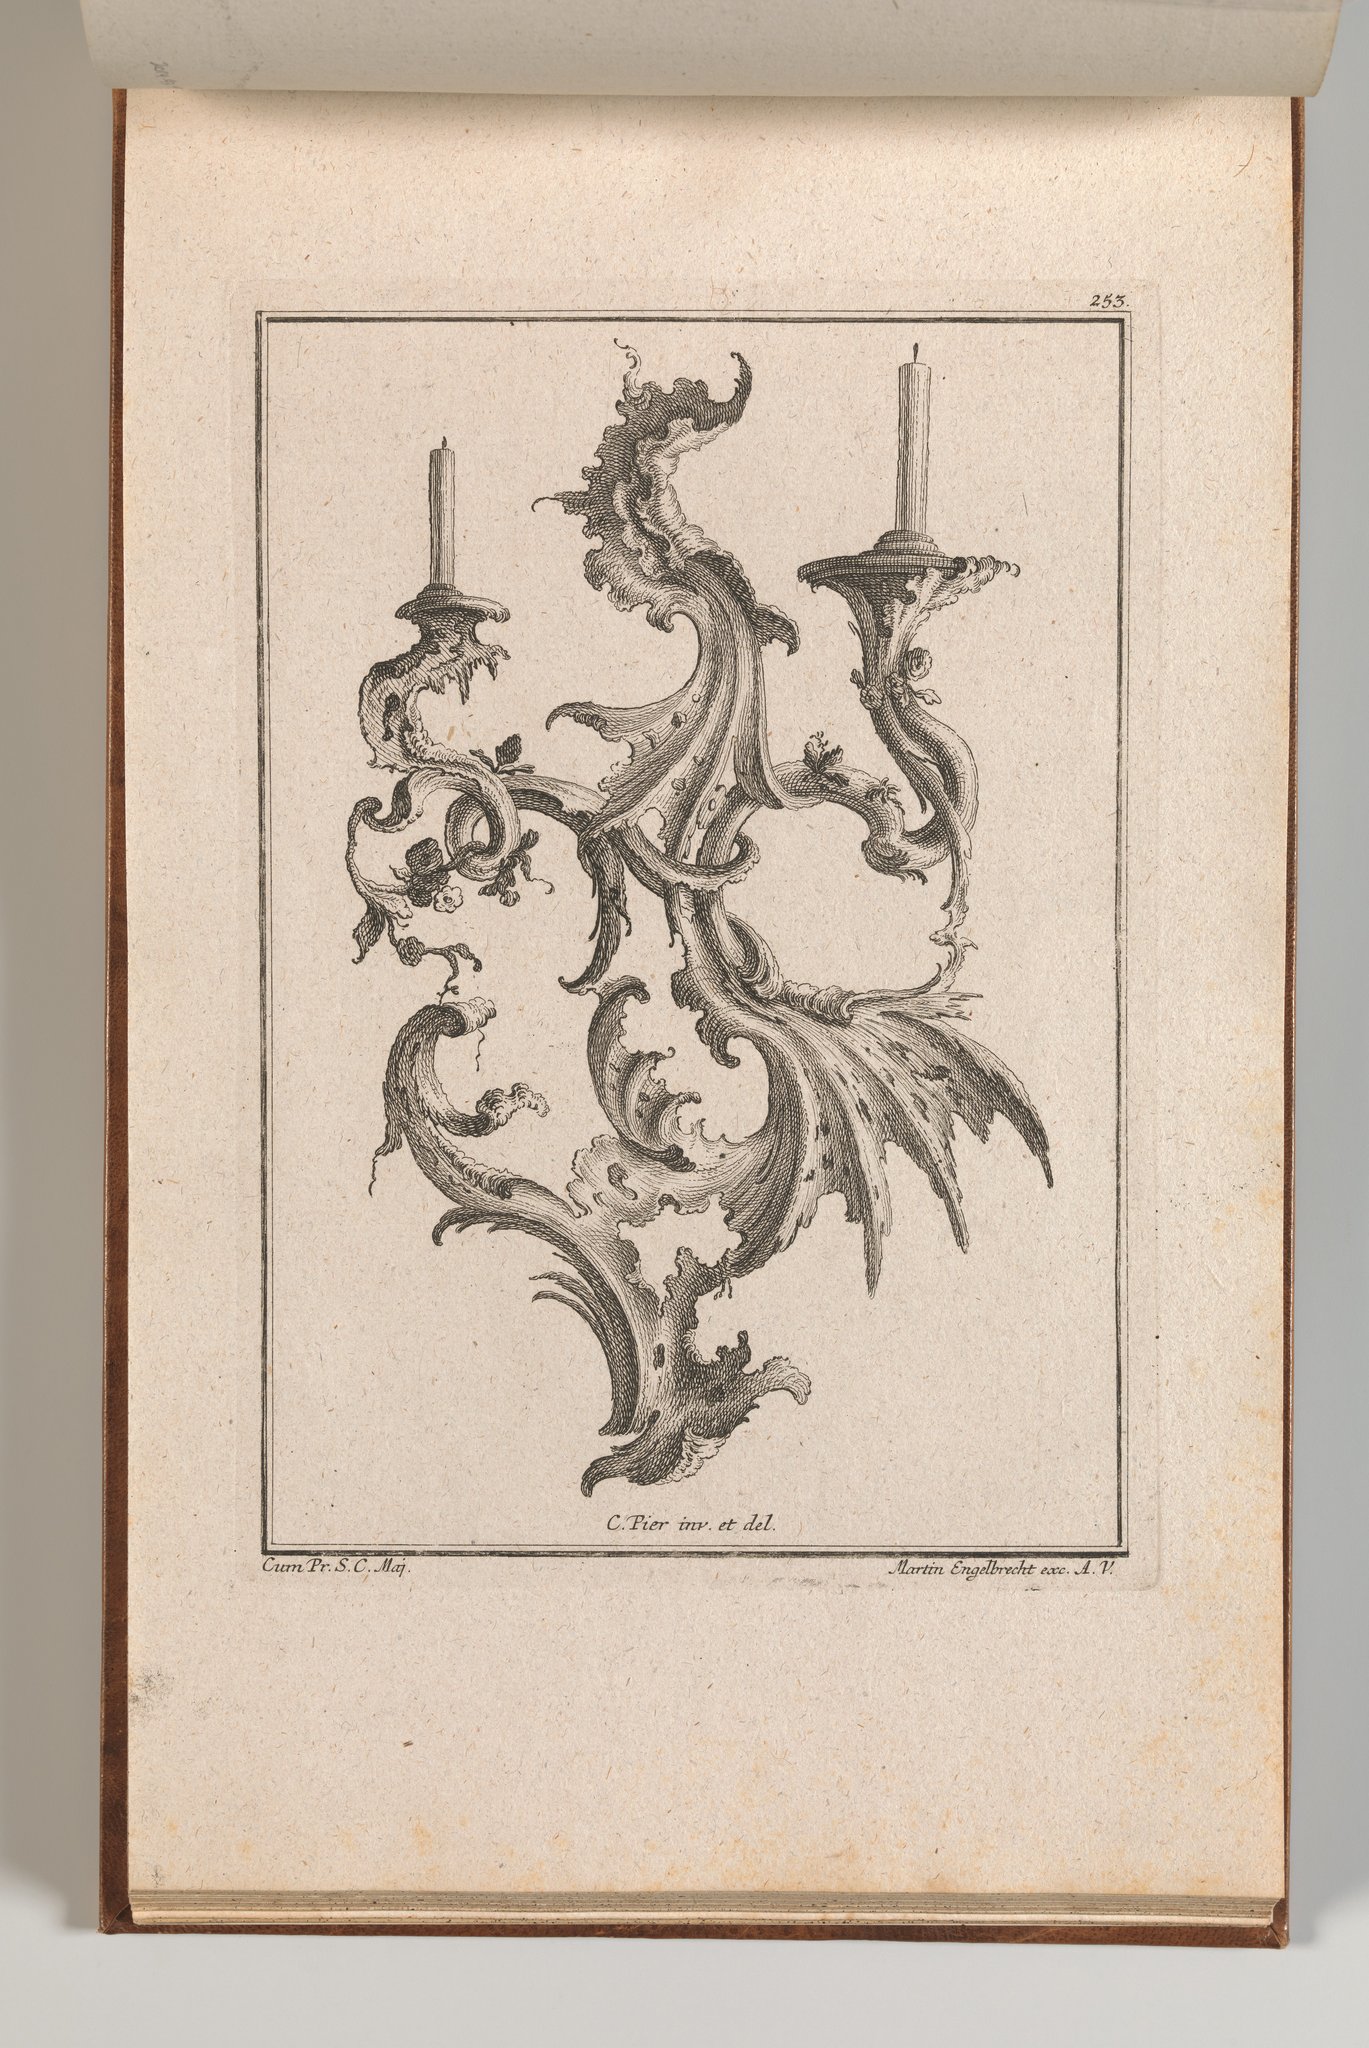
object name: album print ornament architecture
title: Design for a Two-Armed Candelabra, Plate 4 from an Untitled Series of Designs for Suspended Candelabra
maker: carl pier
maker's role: artist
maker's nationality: german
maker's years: 1700-1790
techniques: etching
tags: candelabra